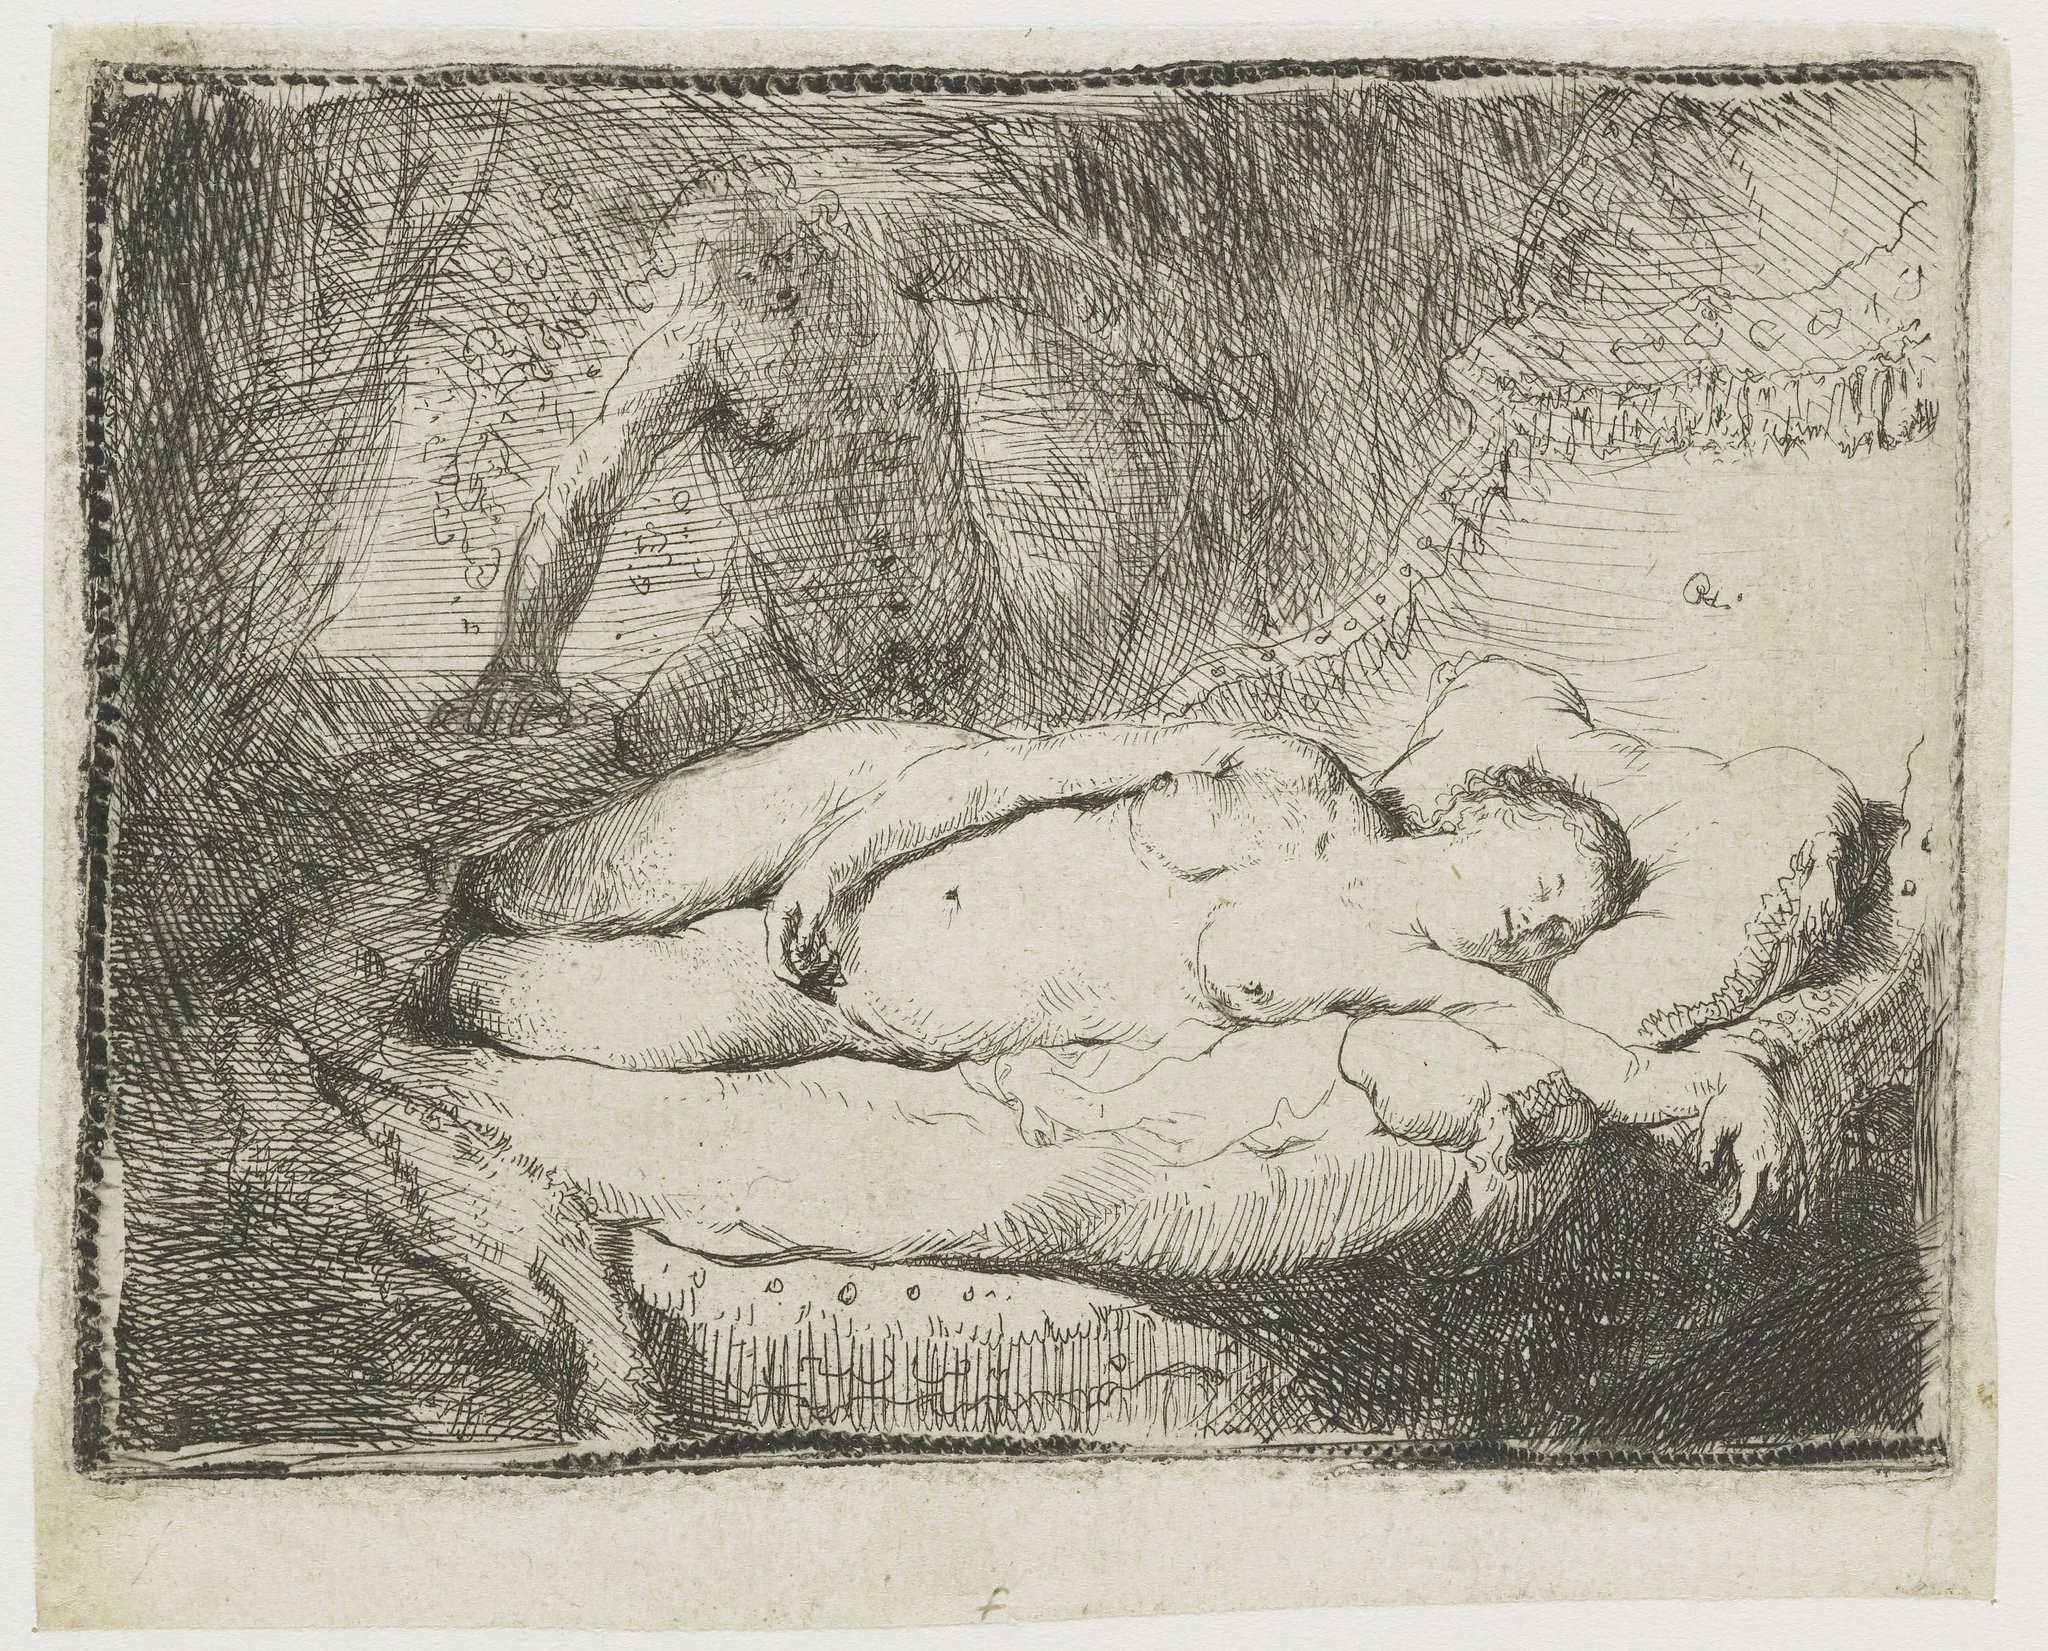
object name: print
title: Jupiter and Antiope: smaller plate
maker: rembrandt van rijn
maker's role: draughtsman, painter, print maker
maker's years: 1606-1669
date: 1631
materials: paper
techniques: etching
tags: jupiter, disguised as a satyr, approaches the sleeping antiope; the eagle may be standing nearby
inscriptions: mark: Lugt 2228, monogram: ‘RHL’